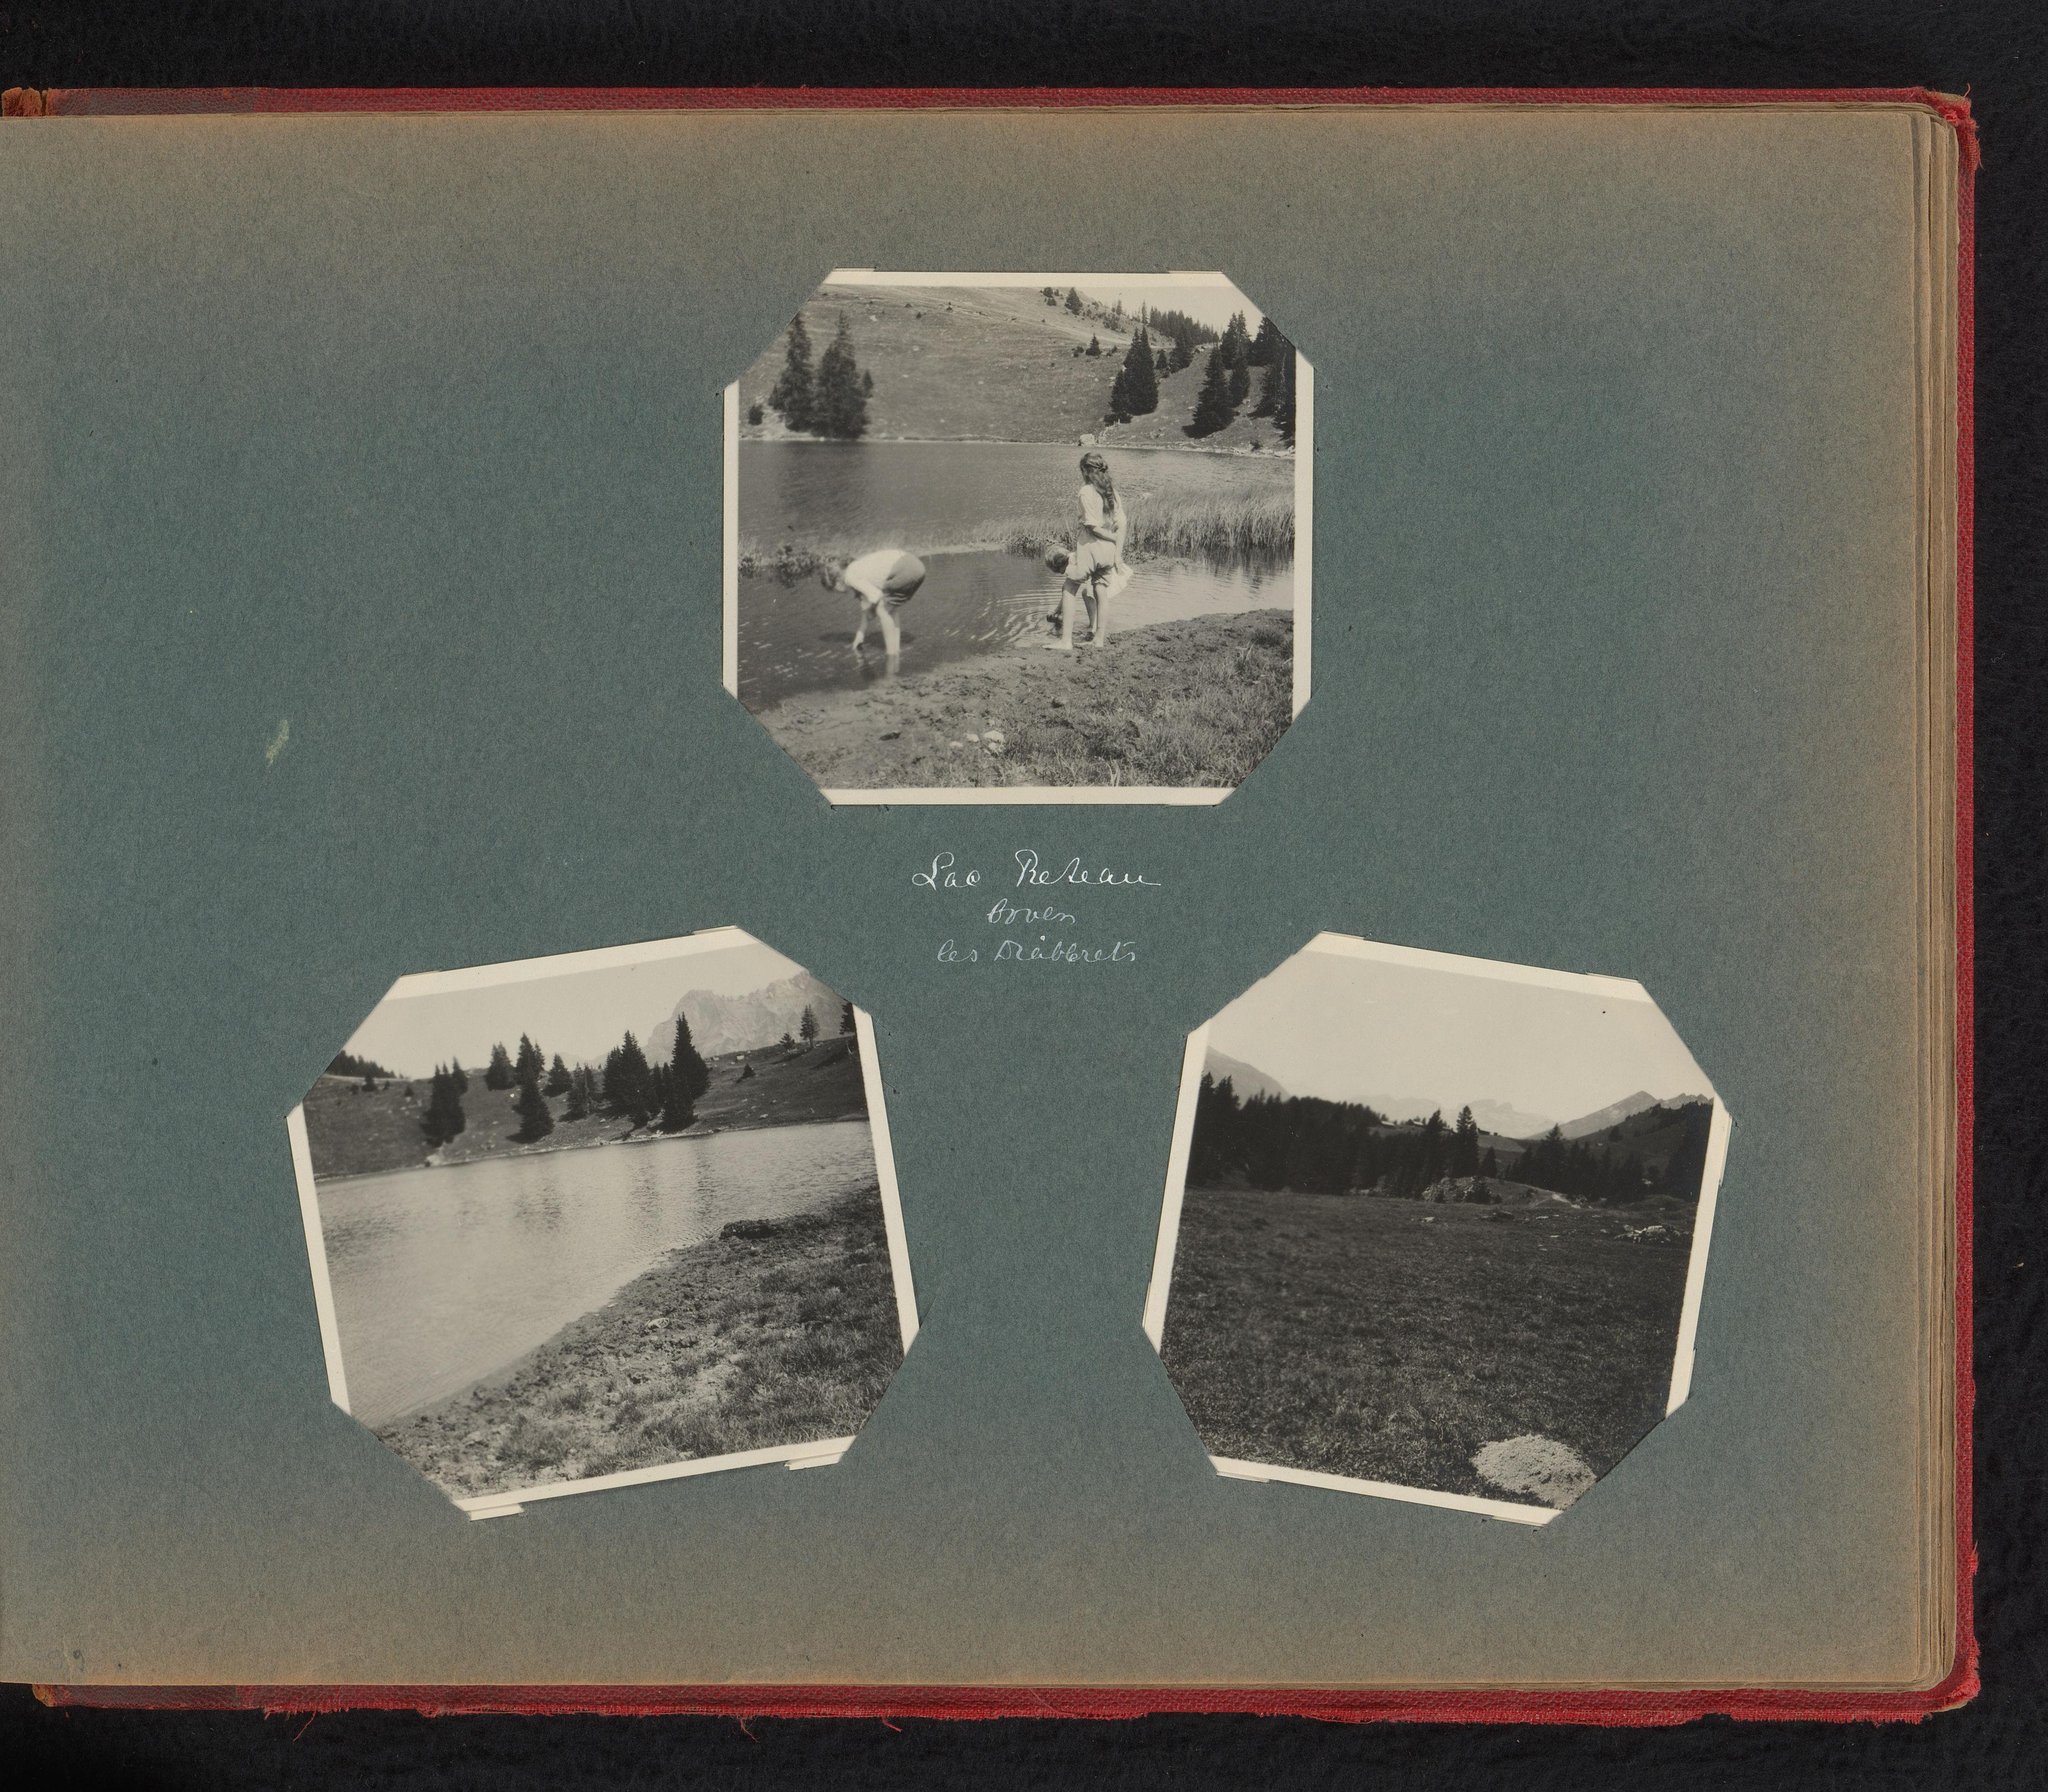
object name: album leaf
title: Lac Beteau boven Les Diablerets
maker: charlotte alida boelen-matthes (lot)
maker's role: amateurfotograaf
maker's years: 1889-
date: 1921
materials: paper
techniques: gelatin silver print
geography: switzerland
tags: lake, mountains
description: Deze foto's zijn onderdeel van een album.